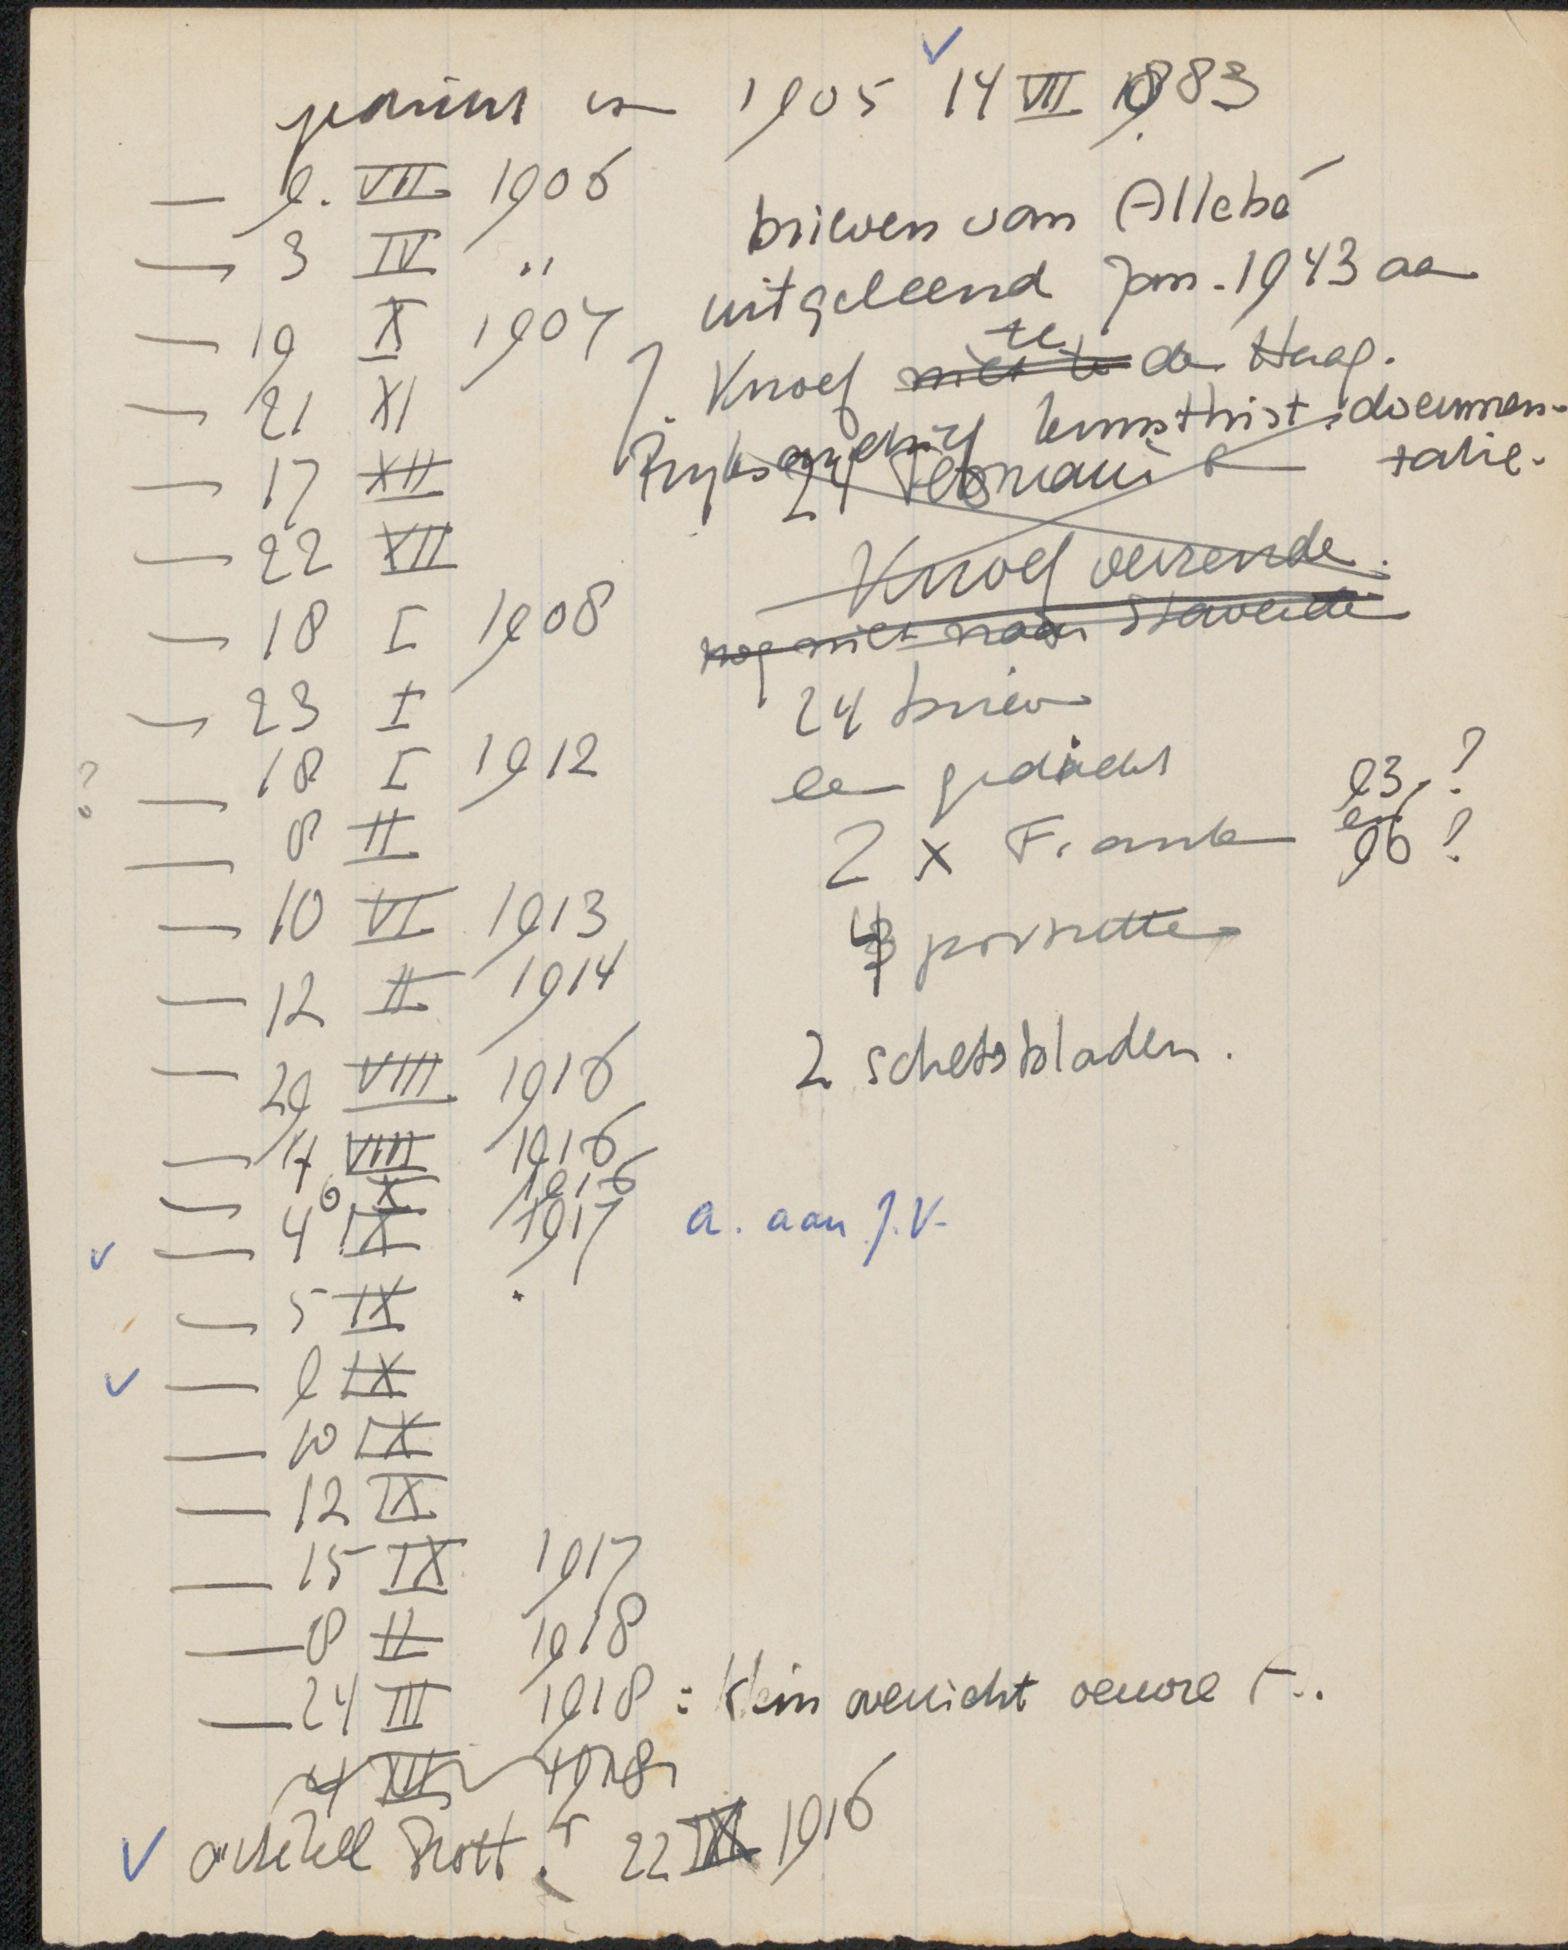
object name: aantekening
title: Aantekening uit archief Jan Veth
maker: Anonymous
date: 1943-1984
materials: ink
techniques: pen, writing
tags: august allebé, dordrecht, amsterdam, painter, print maker, draughtsman, designer, jan veth, jan knoef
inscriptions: collector's mark: ‘RPK’